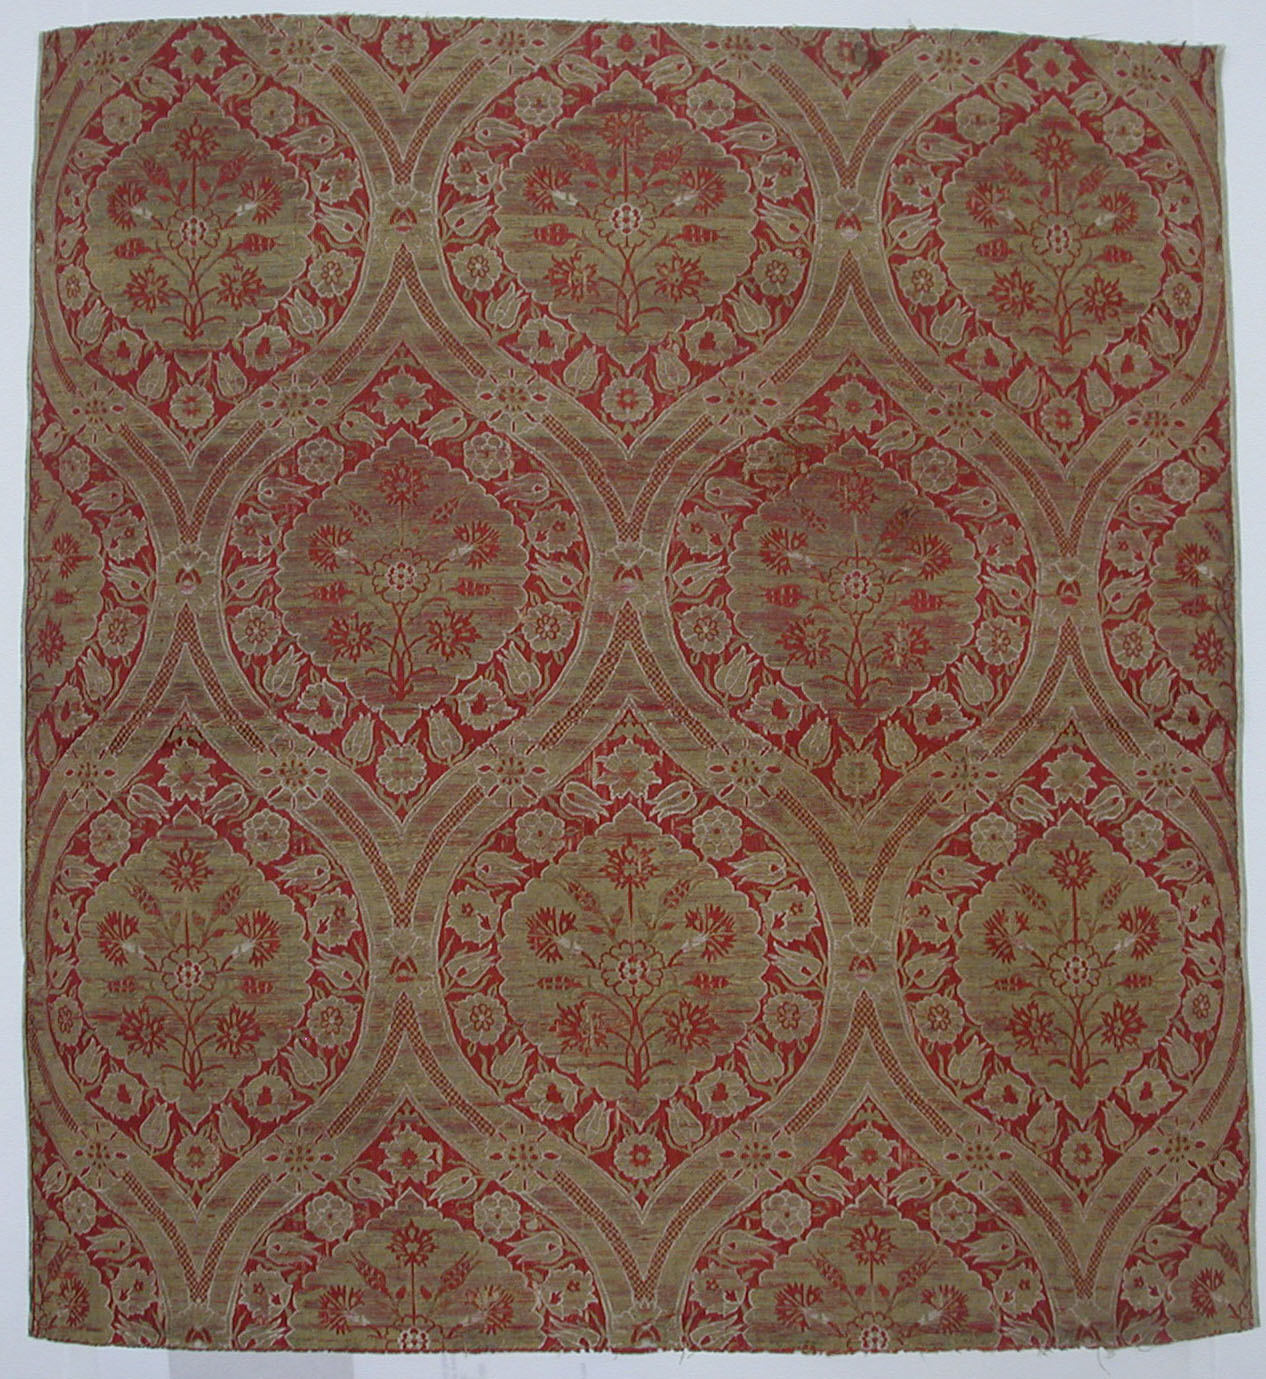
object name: textile fragment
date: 1501-1600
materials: metal thread, silk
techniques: lampas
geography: turkey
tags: flowers